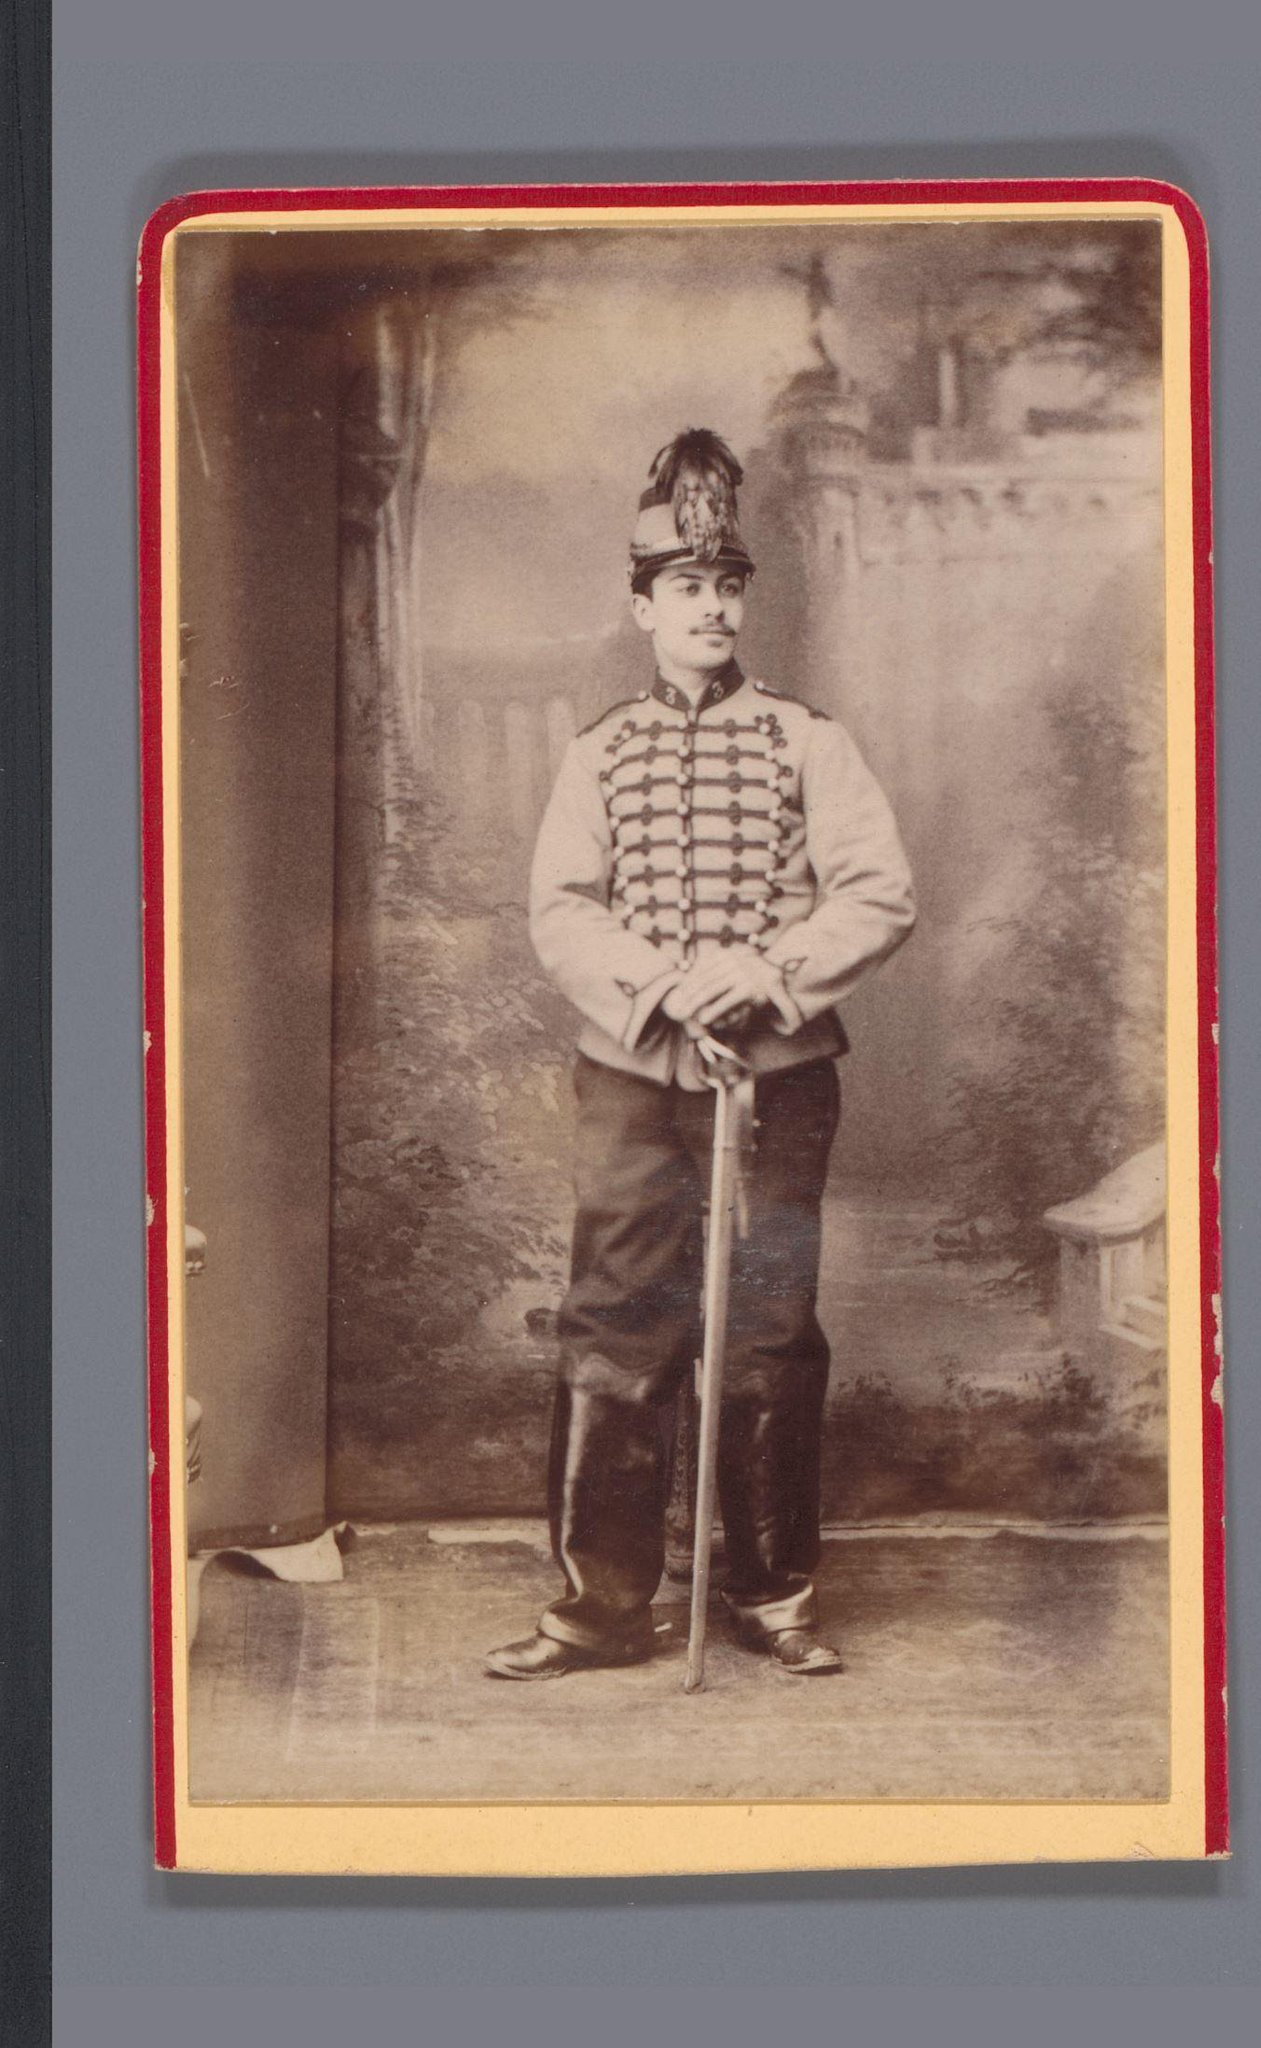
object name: semi enamel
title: Portret van een onbekende jonge man in uniform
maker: Anonymous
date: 1854-1885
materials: cardboard, celluloid, paper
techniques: albumen print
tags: adult man, anonymous historical person portrayed, (military) uniforms